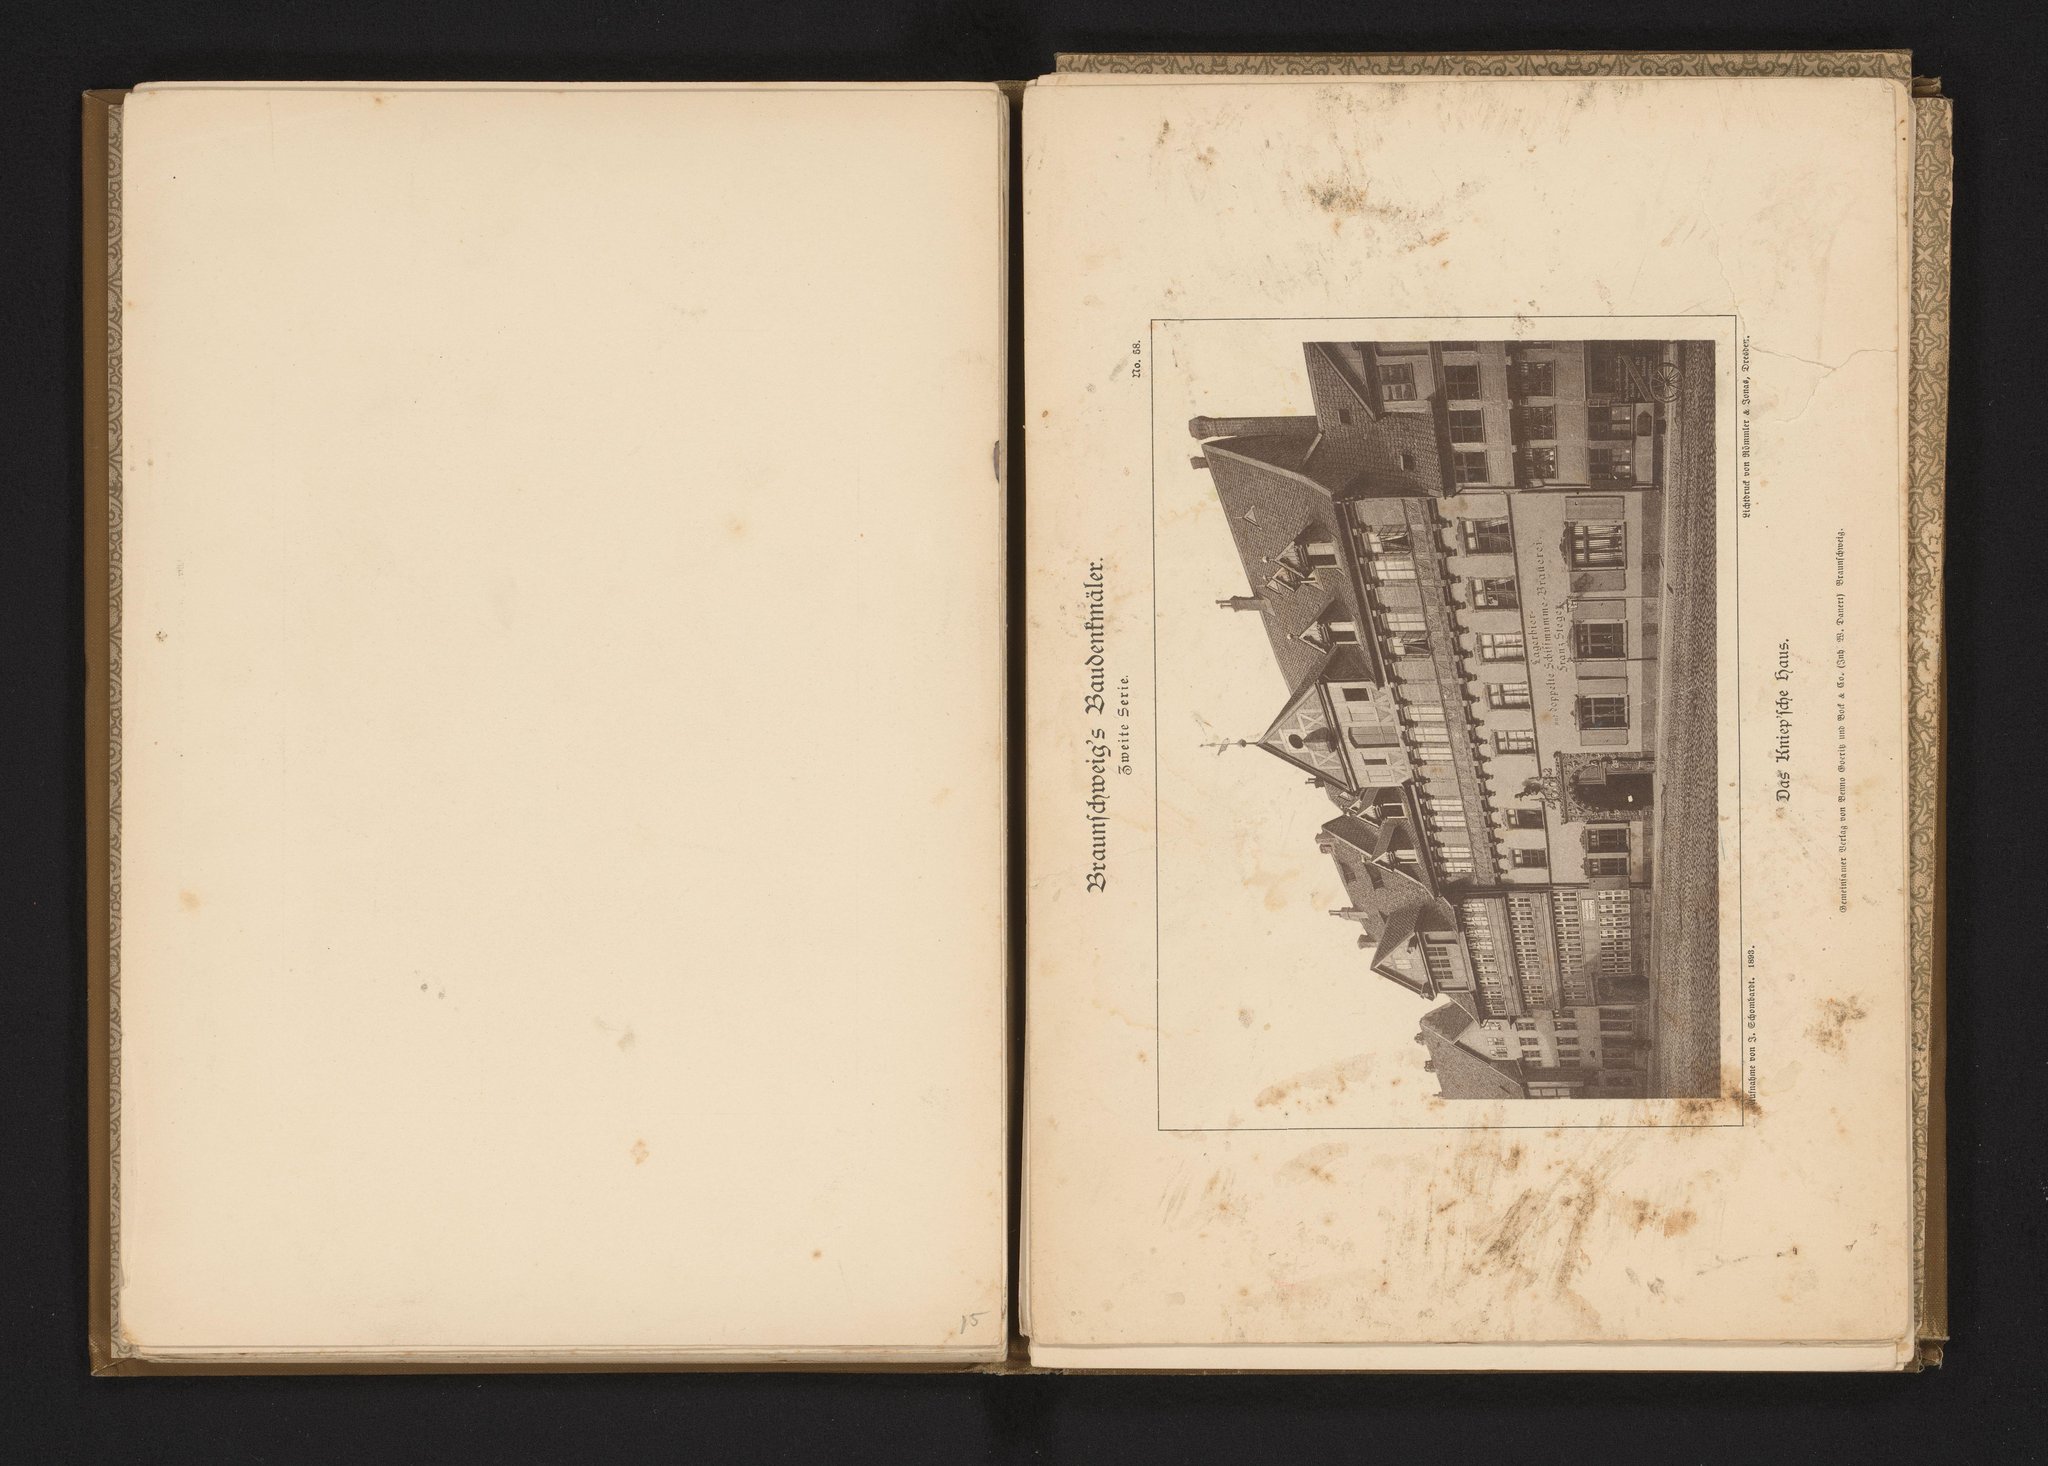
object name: page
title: Braunschweig's Baudenkmäler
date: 1893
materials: paper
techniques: photograph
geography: braunschweig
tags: city-view in general; 'veduta', façade (of house or building)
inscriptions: number: ‘No. 58.’